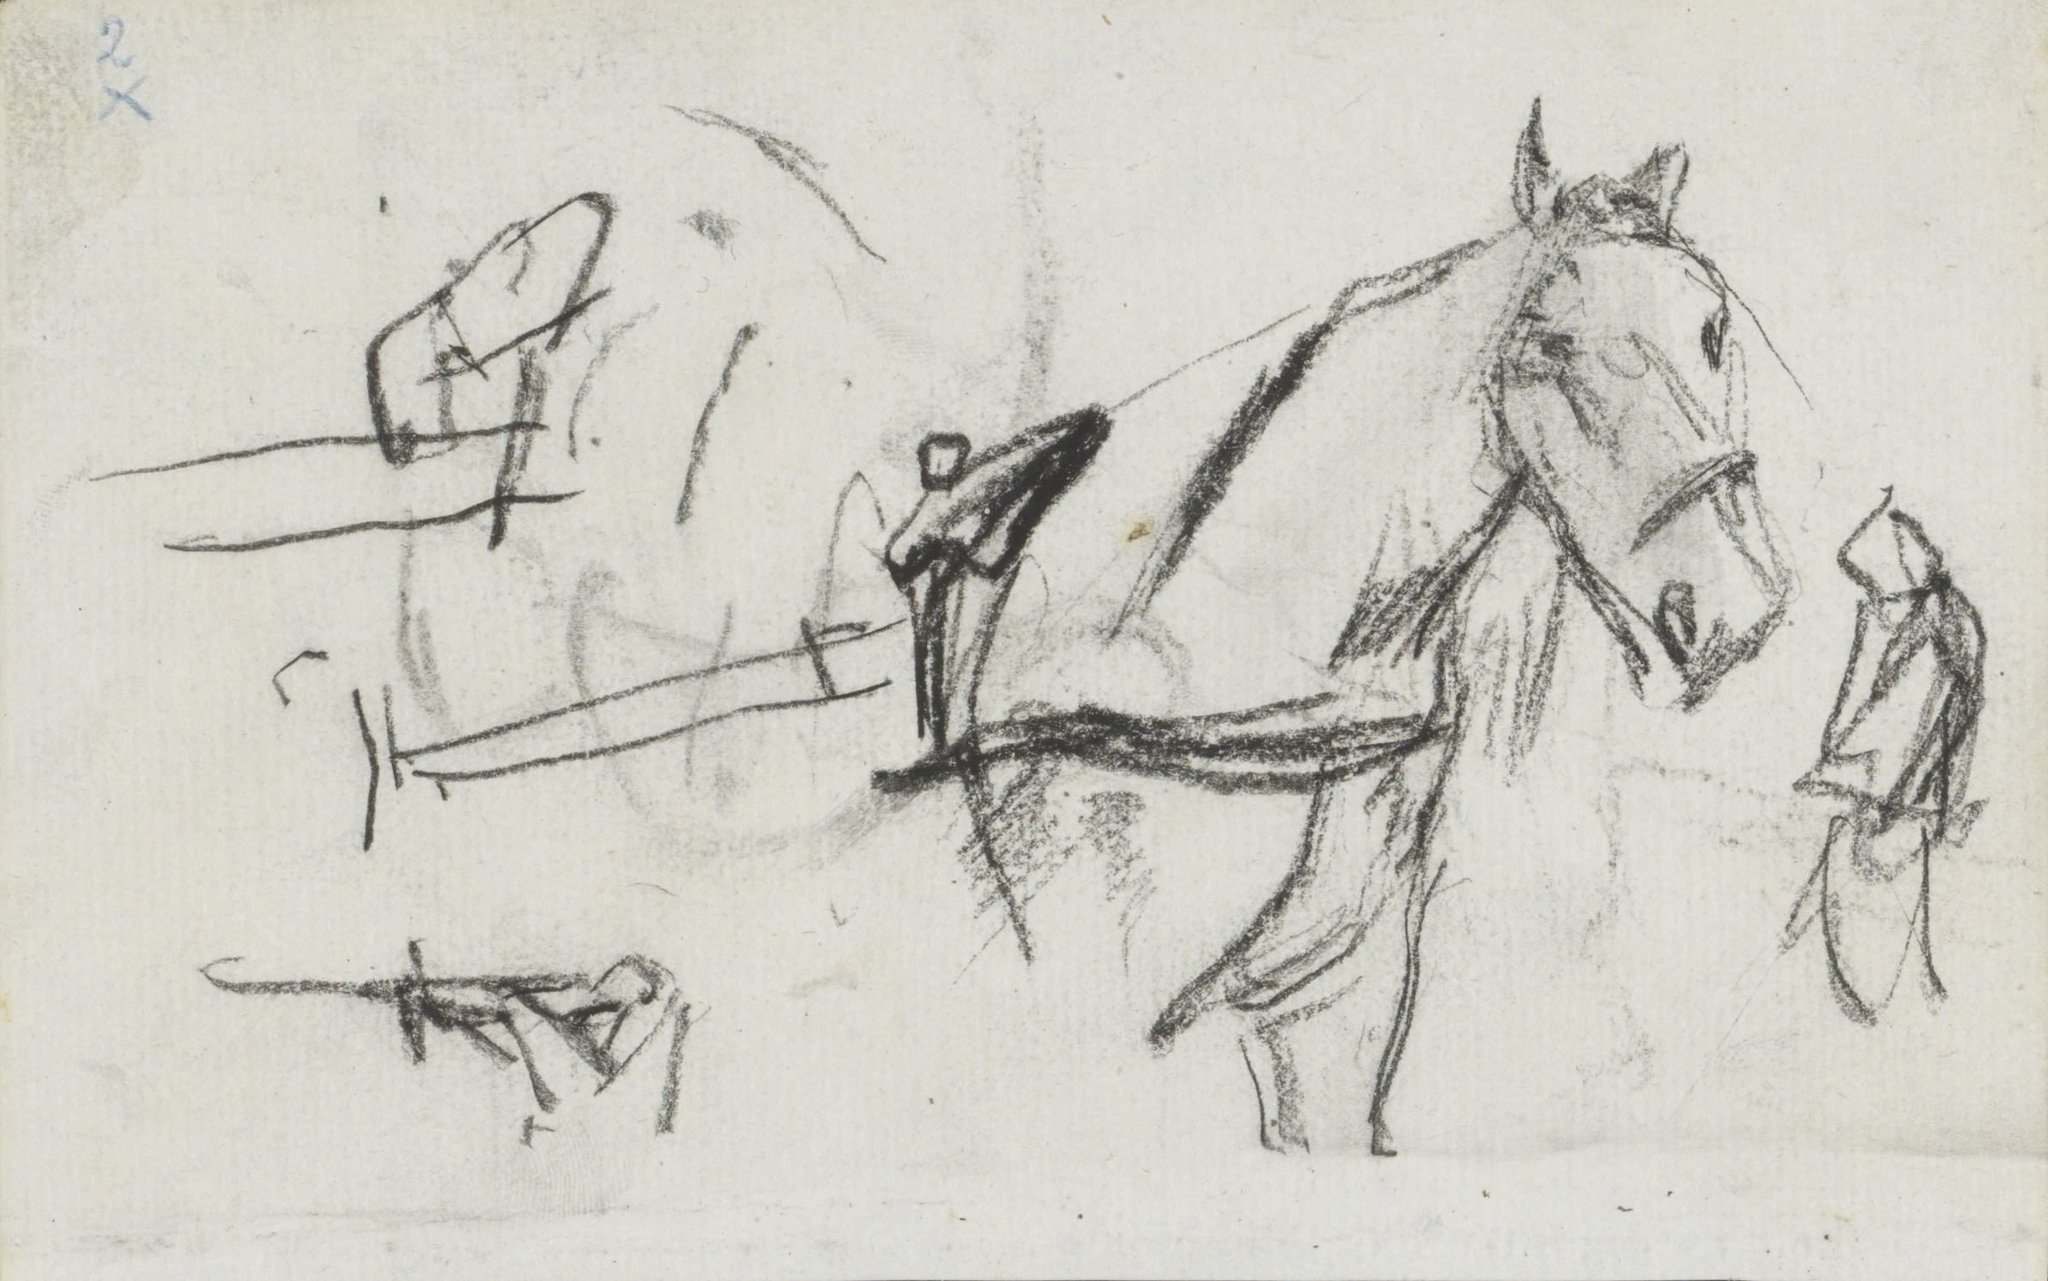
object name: drawing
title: Studieblad met aangespannen paard, disselboom en staande figuur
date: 1906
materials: chalk, paper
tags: standing figure, horse, (farm) wagon, freight wagon, cart